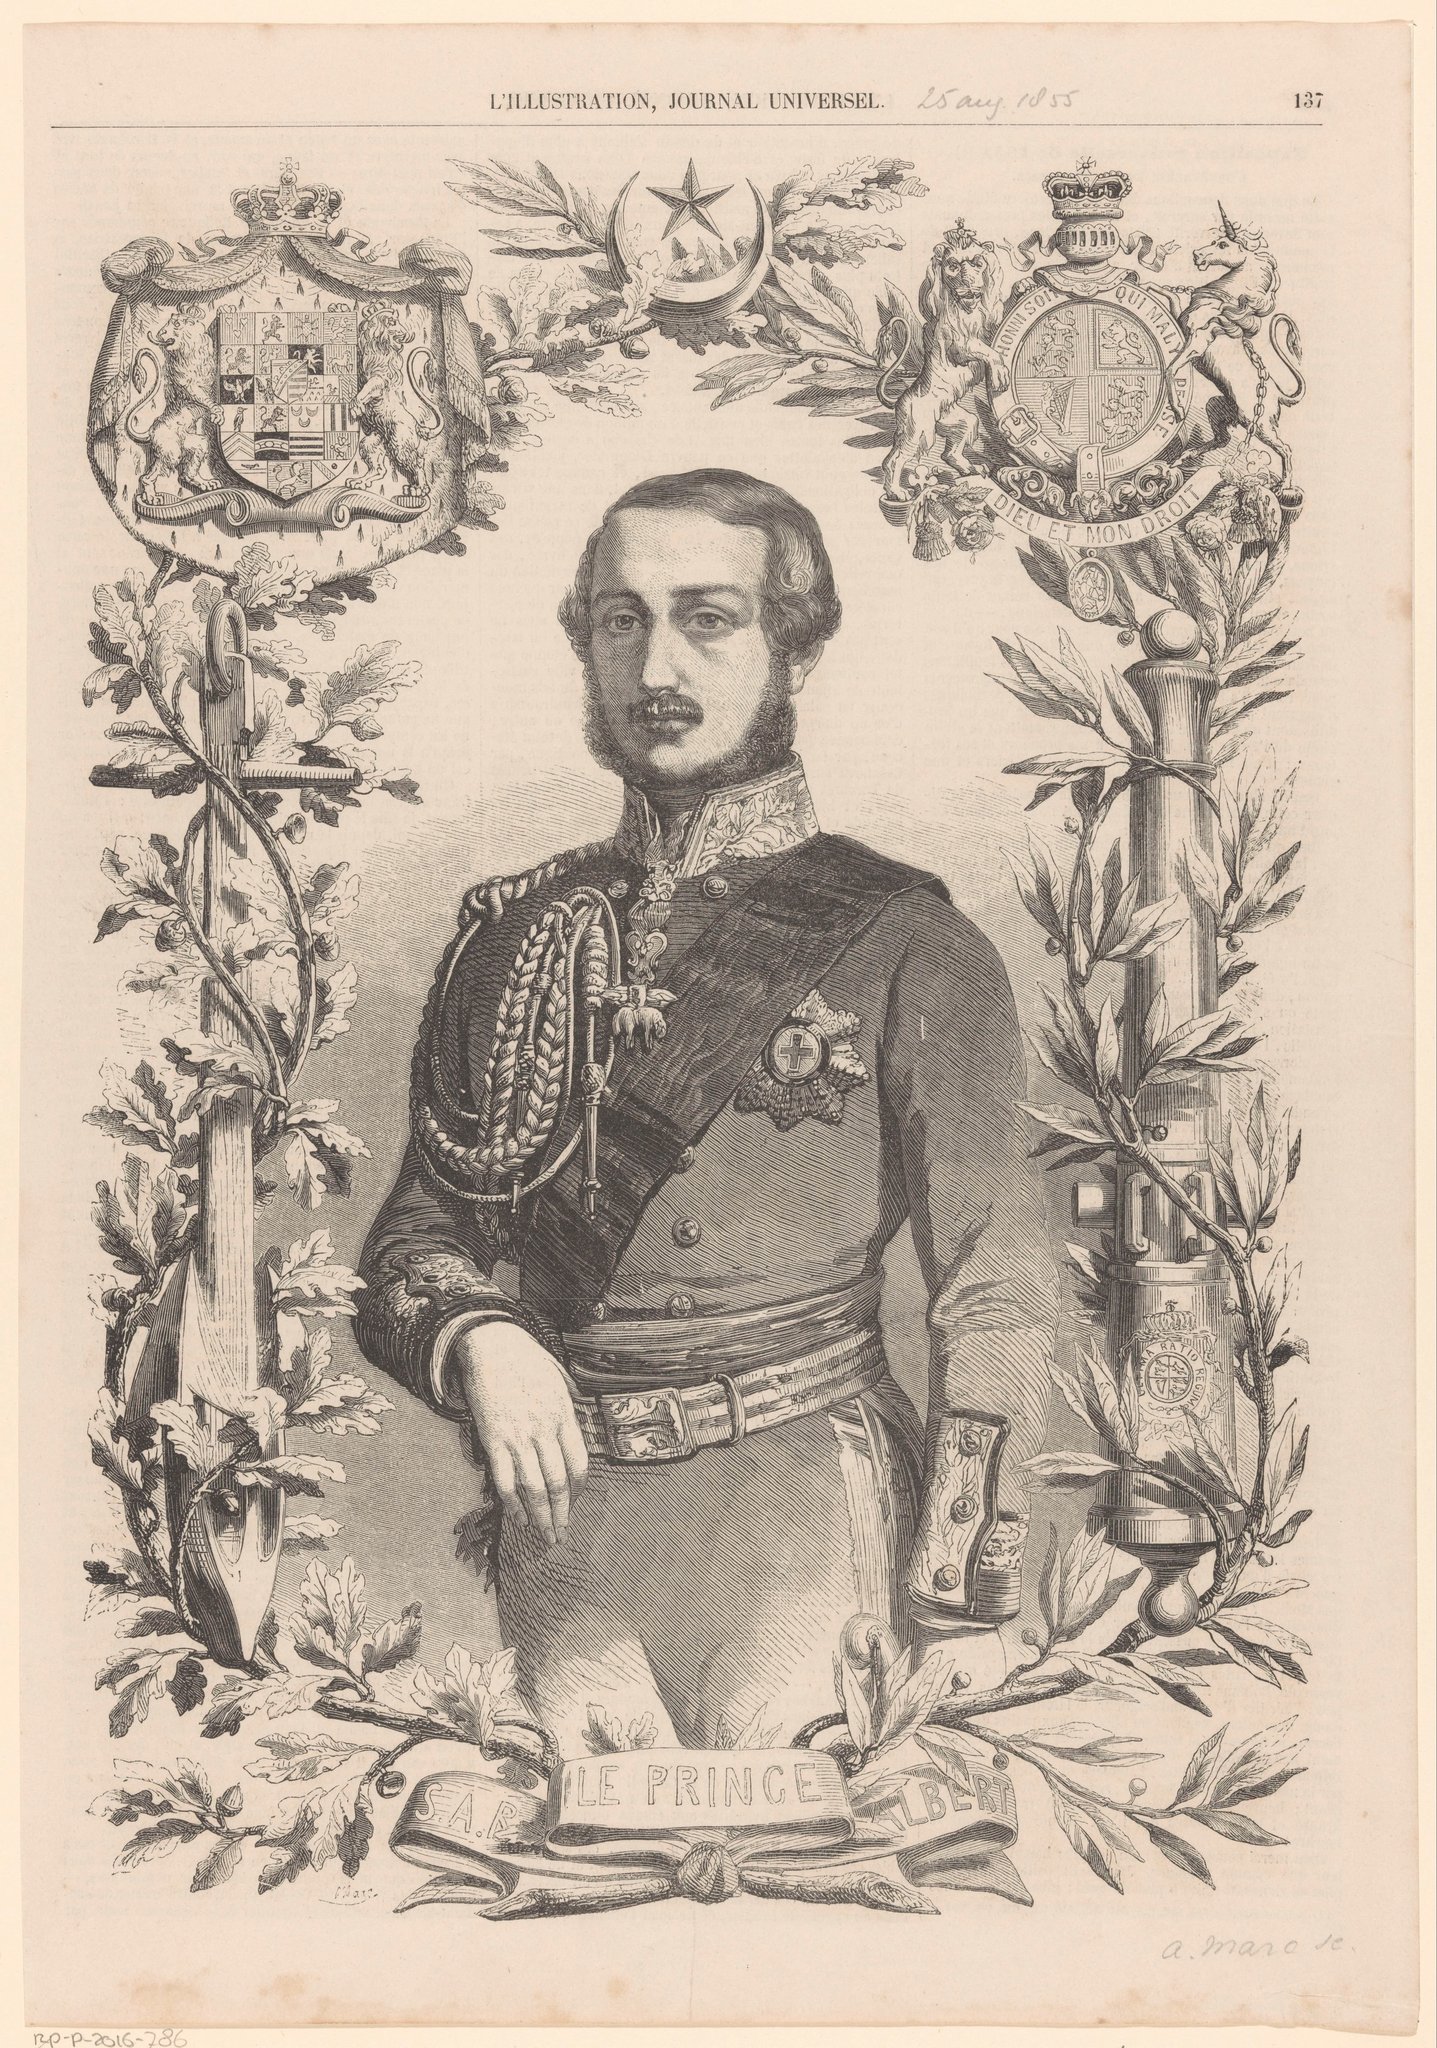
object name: print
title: Portret van Albert, prins van Saksen-Coburg en Gotha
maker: jean auguste marc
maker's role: print maker, publisher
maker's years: 1818-1886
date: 1855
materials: paper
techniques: letterpress printing, engraving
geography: france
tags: albert (prins van saksen-coburg en gotha)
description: Linksboven zijn wapen. Rechtsboven het wapen van Victoria, koningin van Groot-Britannie en Ierland.